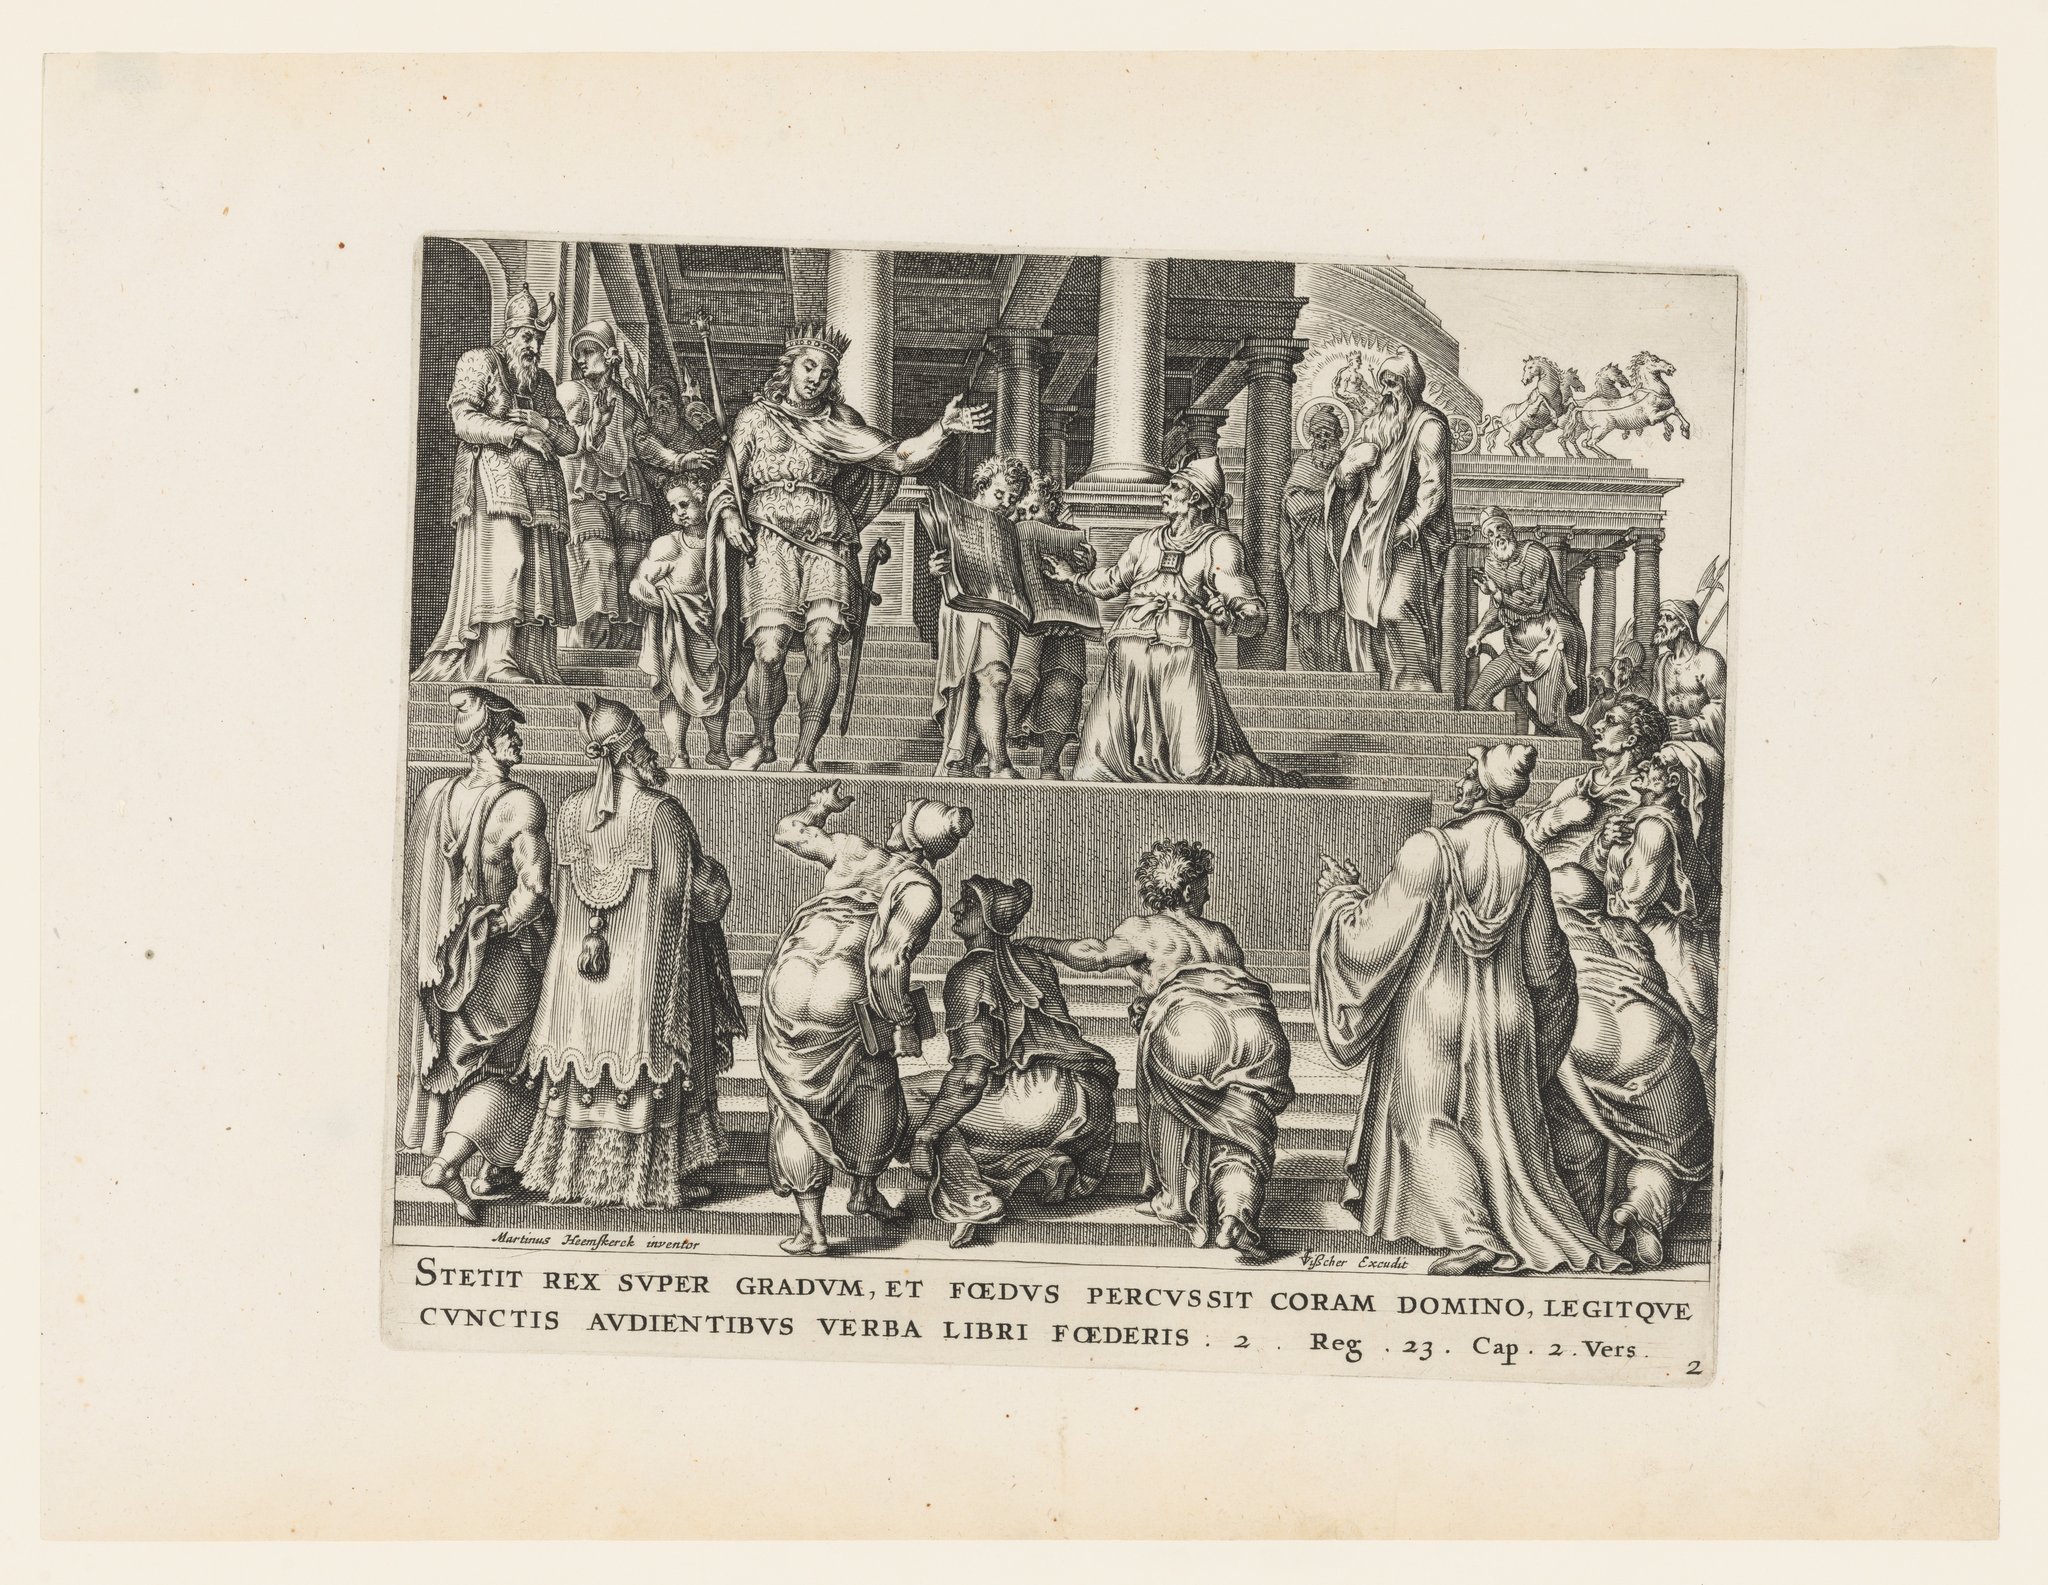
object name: print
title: The Book of Law Read before the People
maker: claes jansz. visscher (ii)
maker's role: artist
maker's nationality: dutch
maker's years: 1586-1652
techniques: engraving